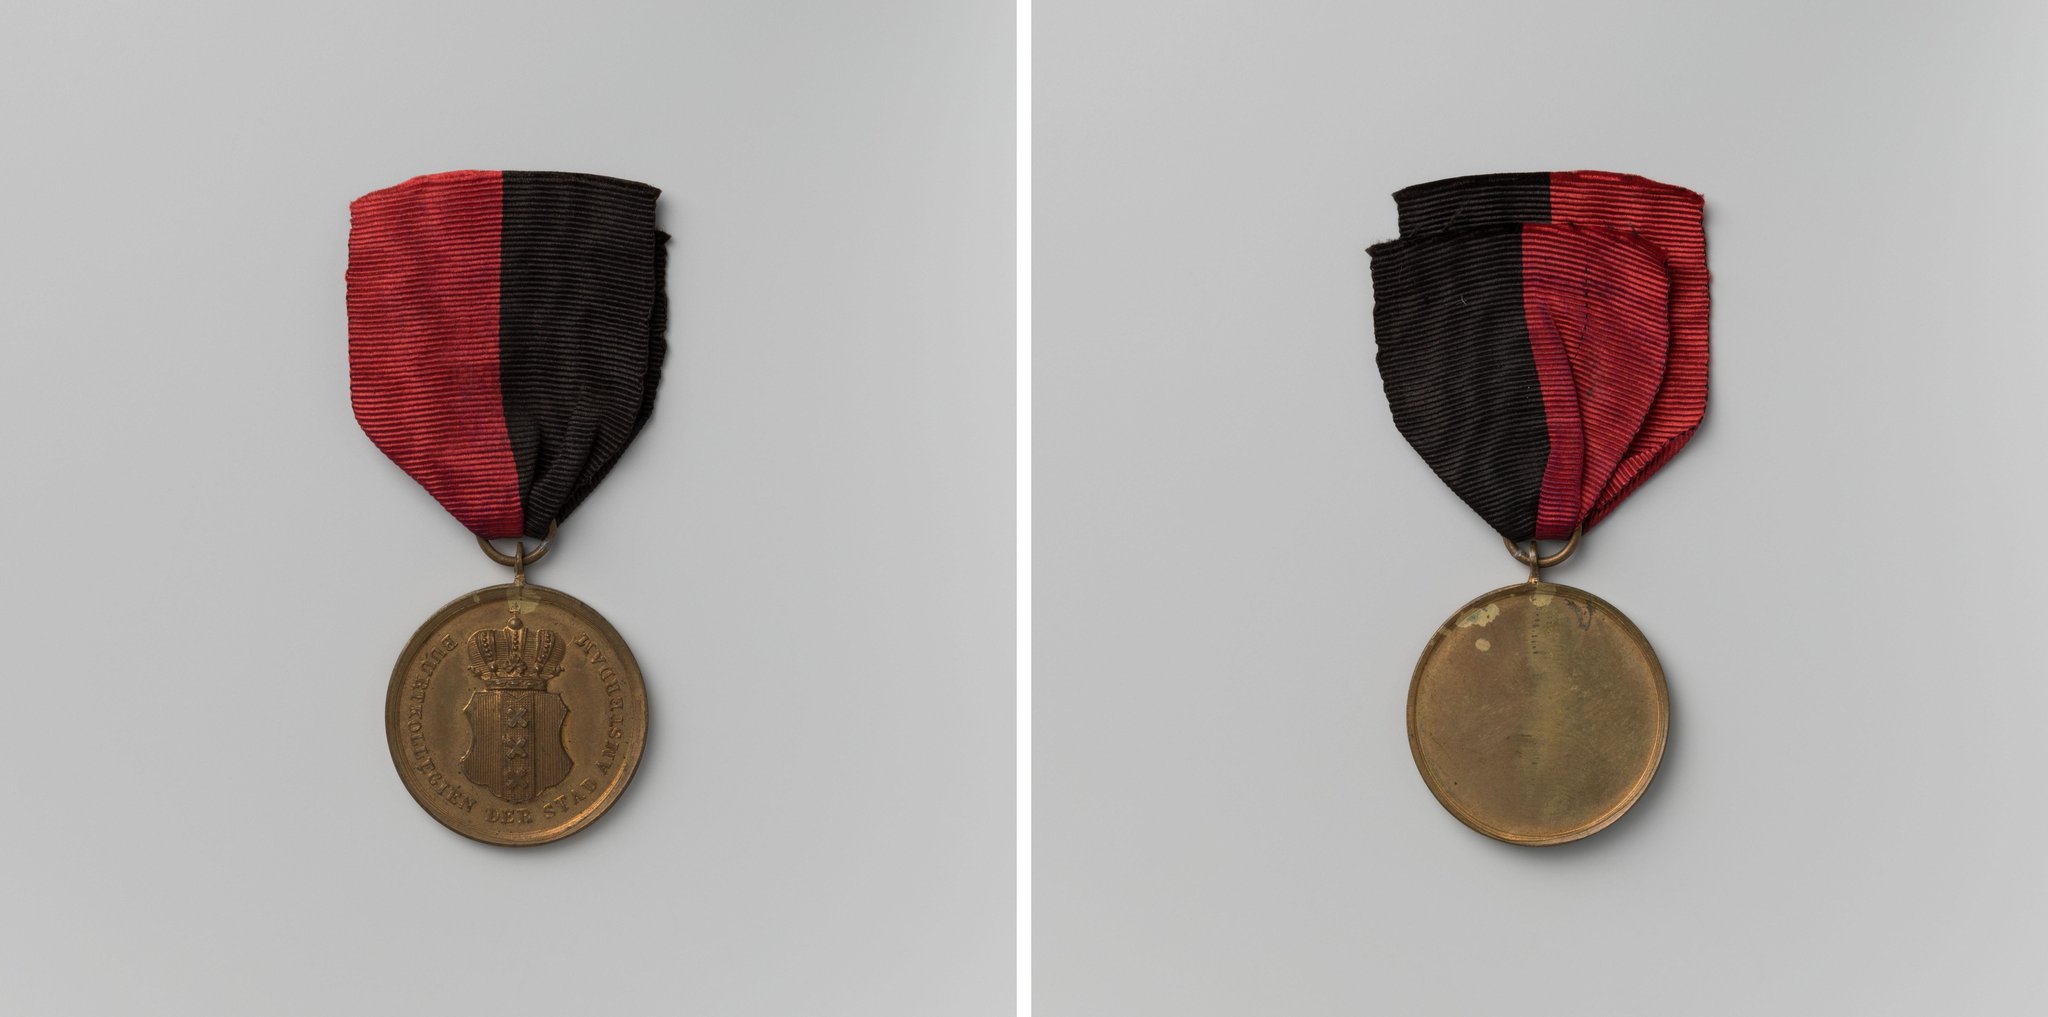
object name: insignia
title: Buurtcommissaris van Amsterdam, draagteken om toegang te verlenen tot het terrein van de brand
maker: Anonymous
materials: brass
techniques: striking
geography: amsterdam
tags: amsterdam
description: Eenzijdige messing penning aan lint met een zwarte en een rode verticale baan. Voorzijde: gekroond wapenschild binnen omschrift. Keerzijde: blanco.